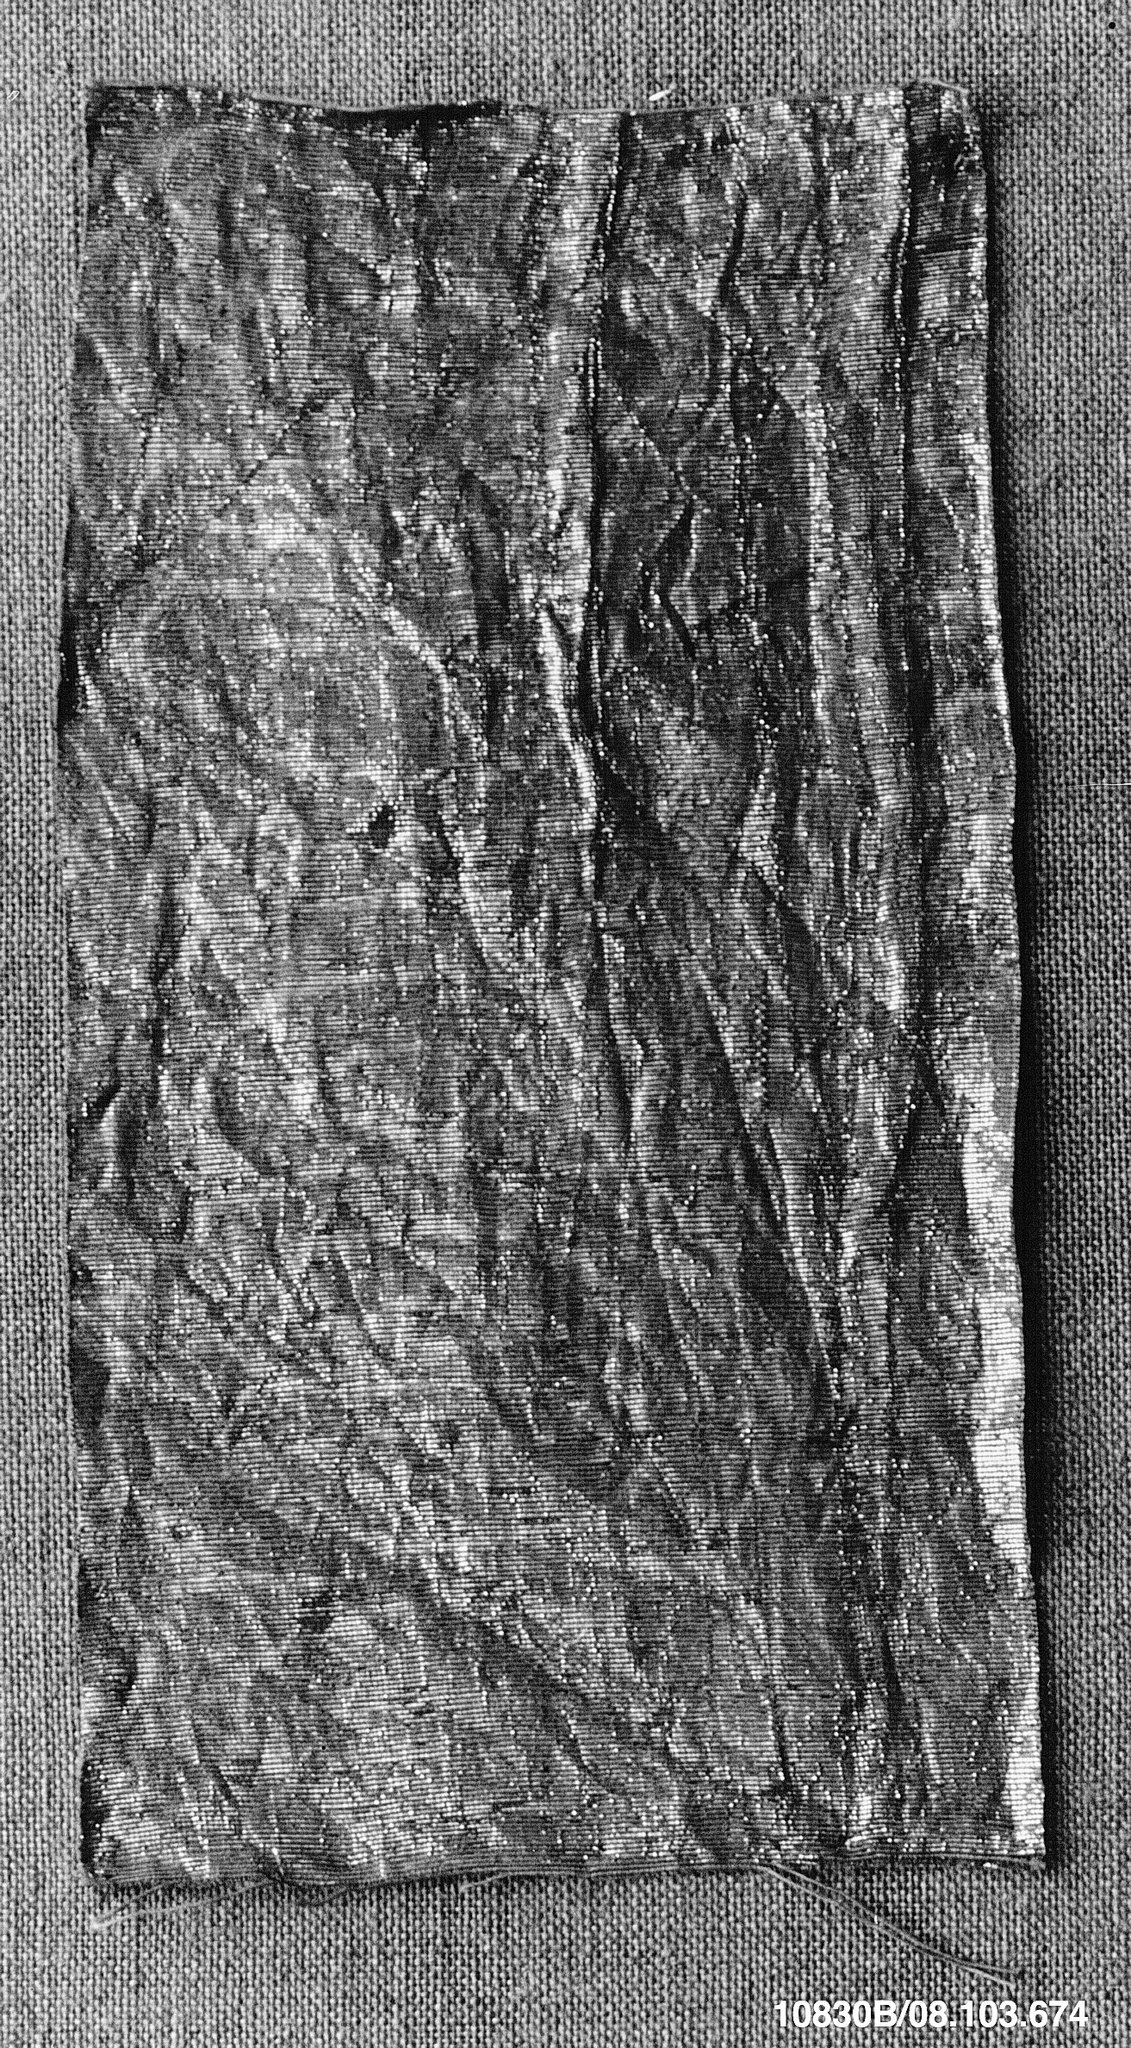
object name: piece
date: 1801-1833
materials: gold, thread